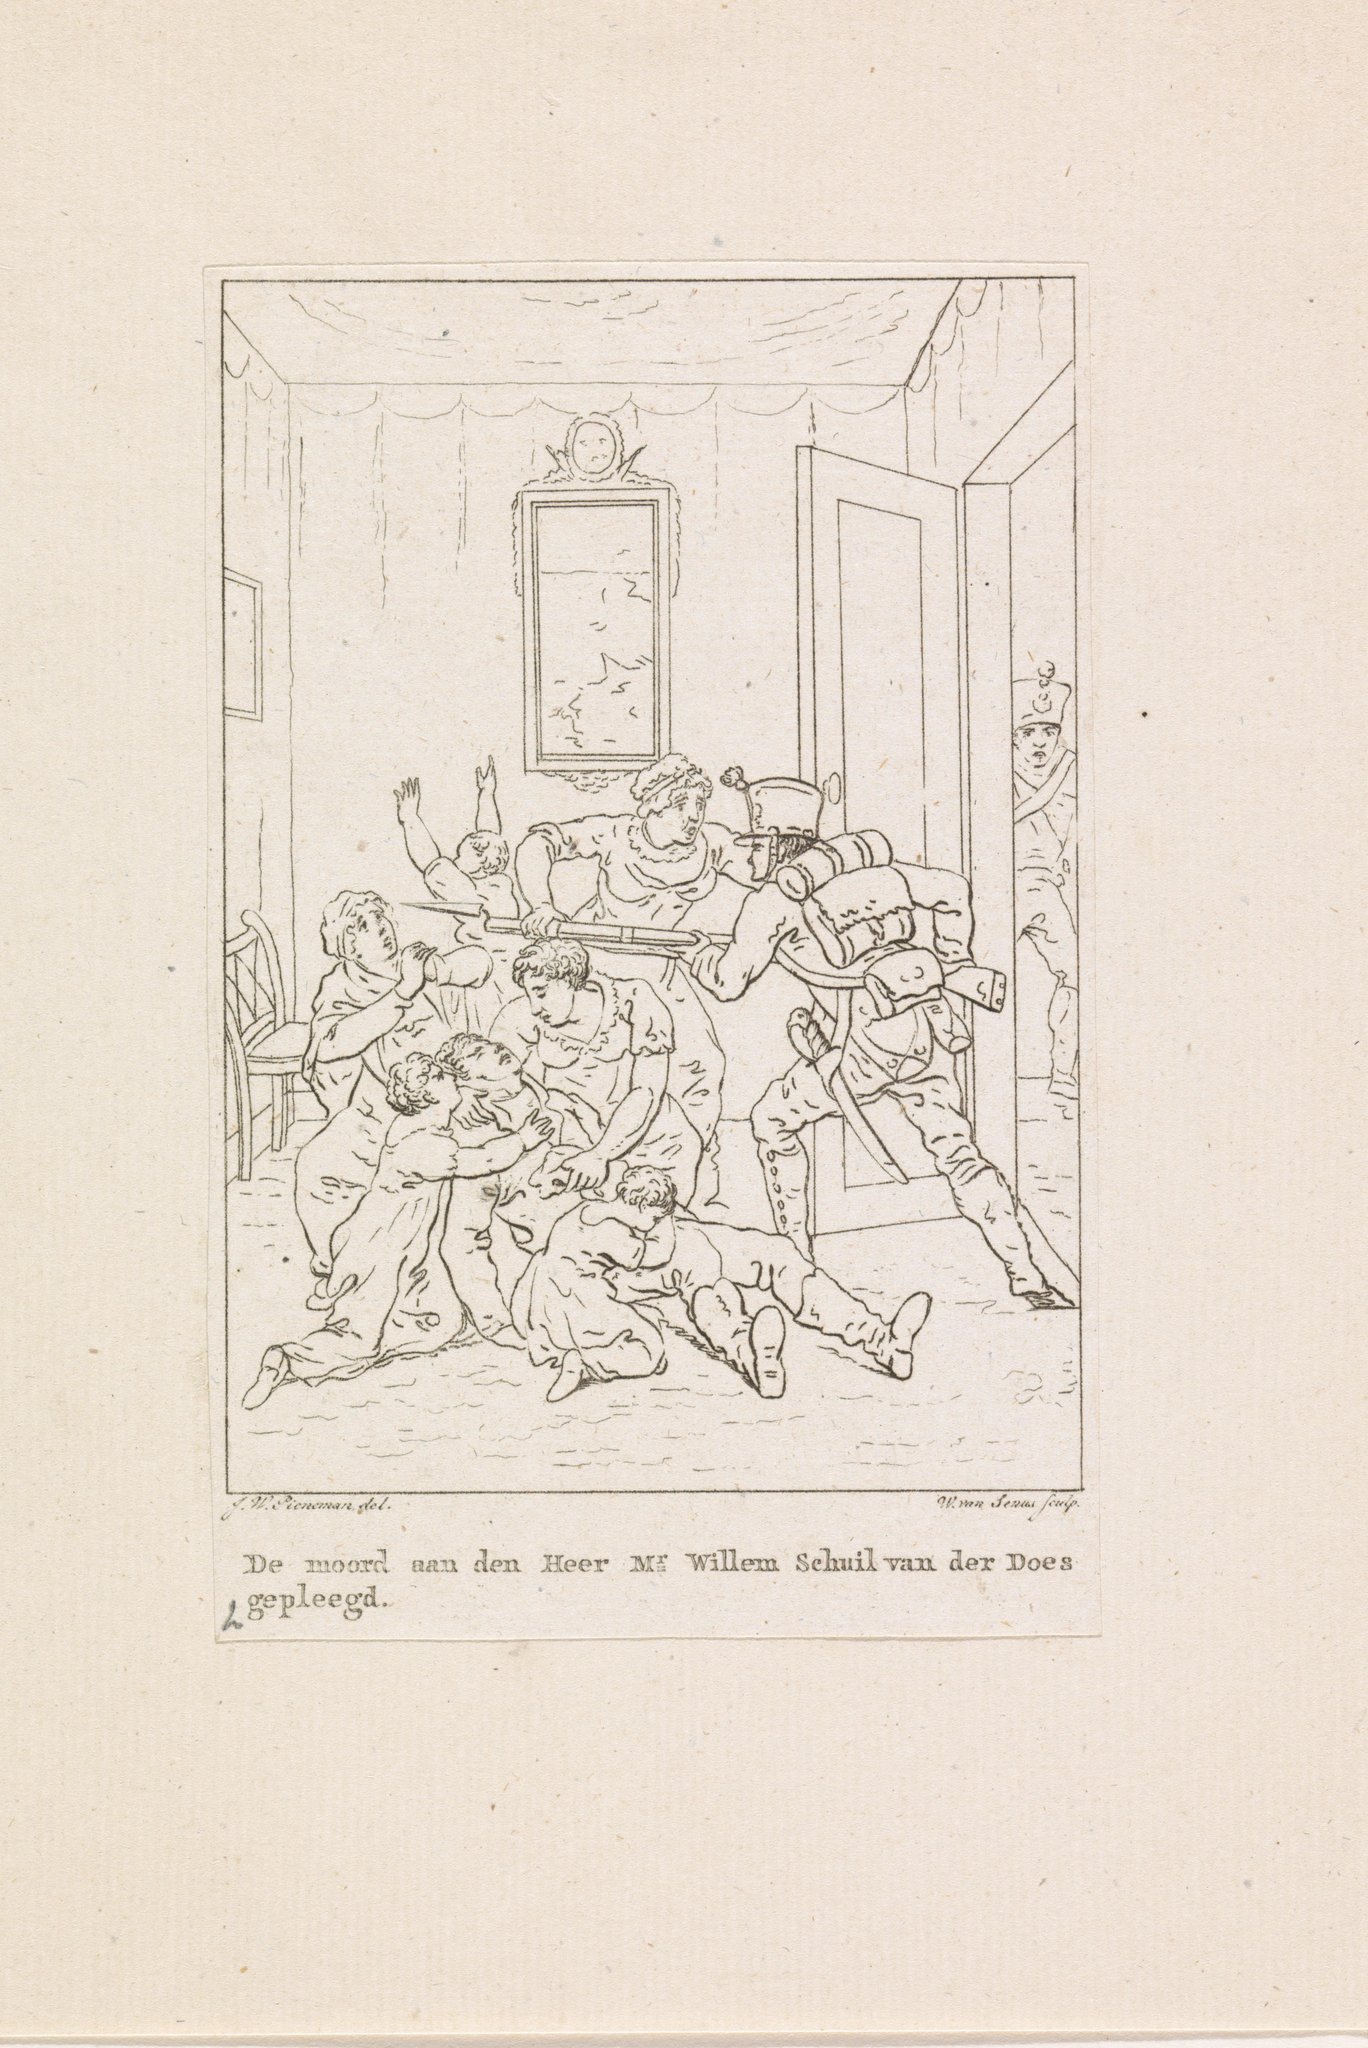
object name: print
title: De moord aan den Heer Mr. Willem Schuil van der Does gepleegd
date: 1813-1814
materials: paper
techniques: etching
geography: netherlands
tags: war and crime, murder, plundering ~ soldiers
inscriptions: collector's mark: Lugt 2228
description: Willem Schuil van der Does in zijn huiskamer ten overstaan van de familie vermoord door Franse militairen. Onderdeel van een groep illustraties in omtrek van de gruwelijkheden begaan door de Franse troepen tijdens de overrompeling en plundering van Woerden op 24 en 25 november 1813.